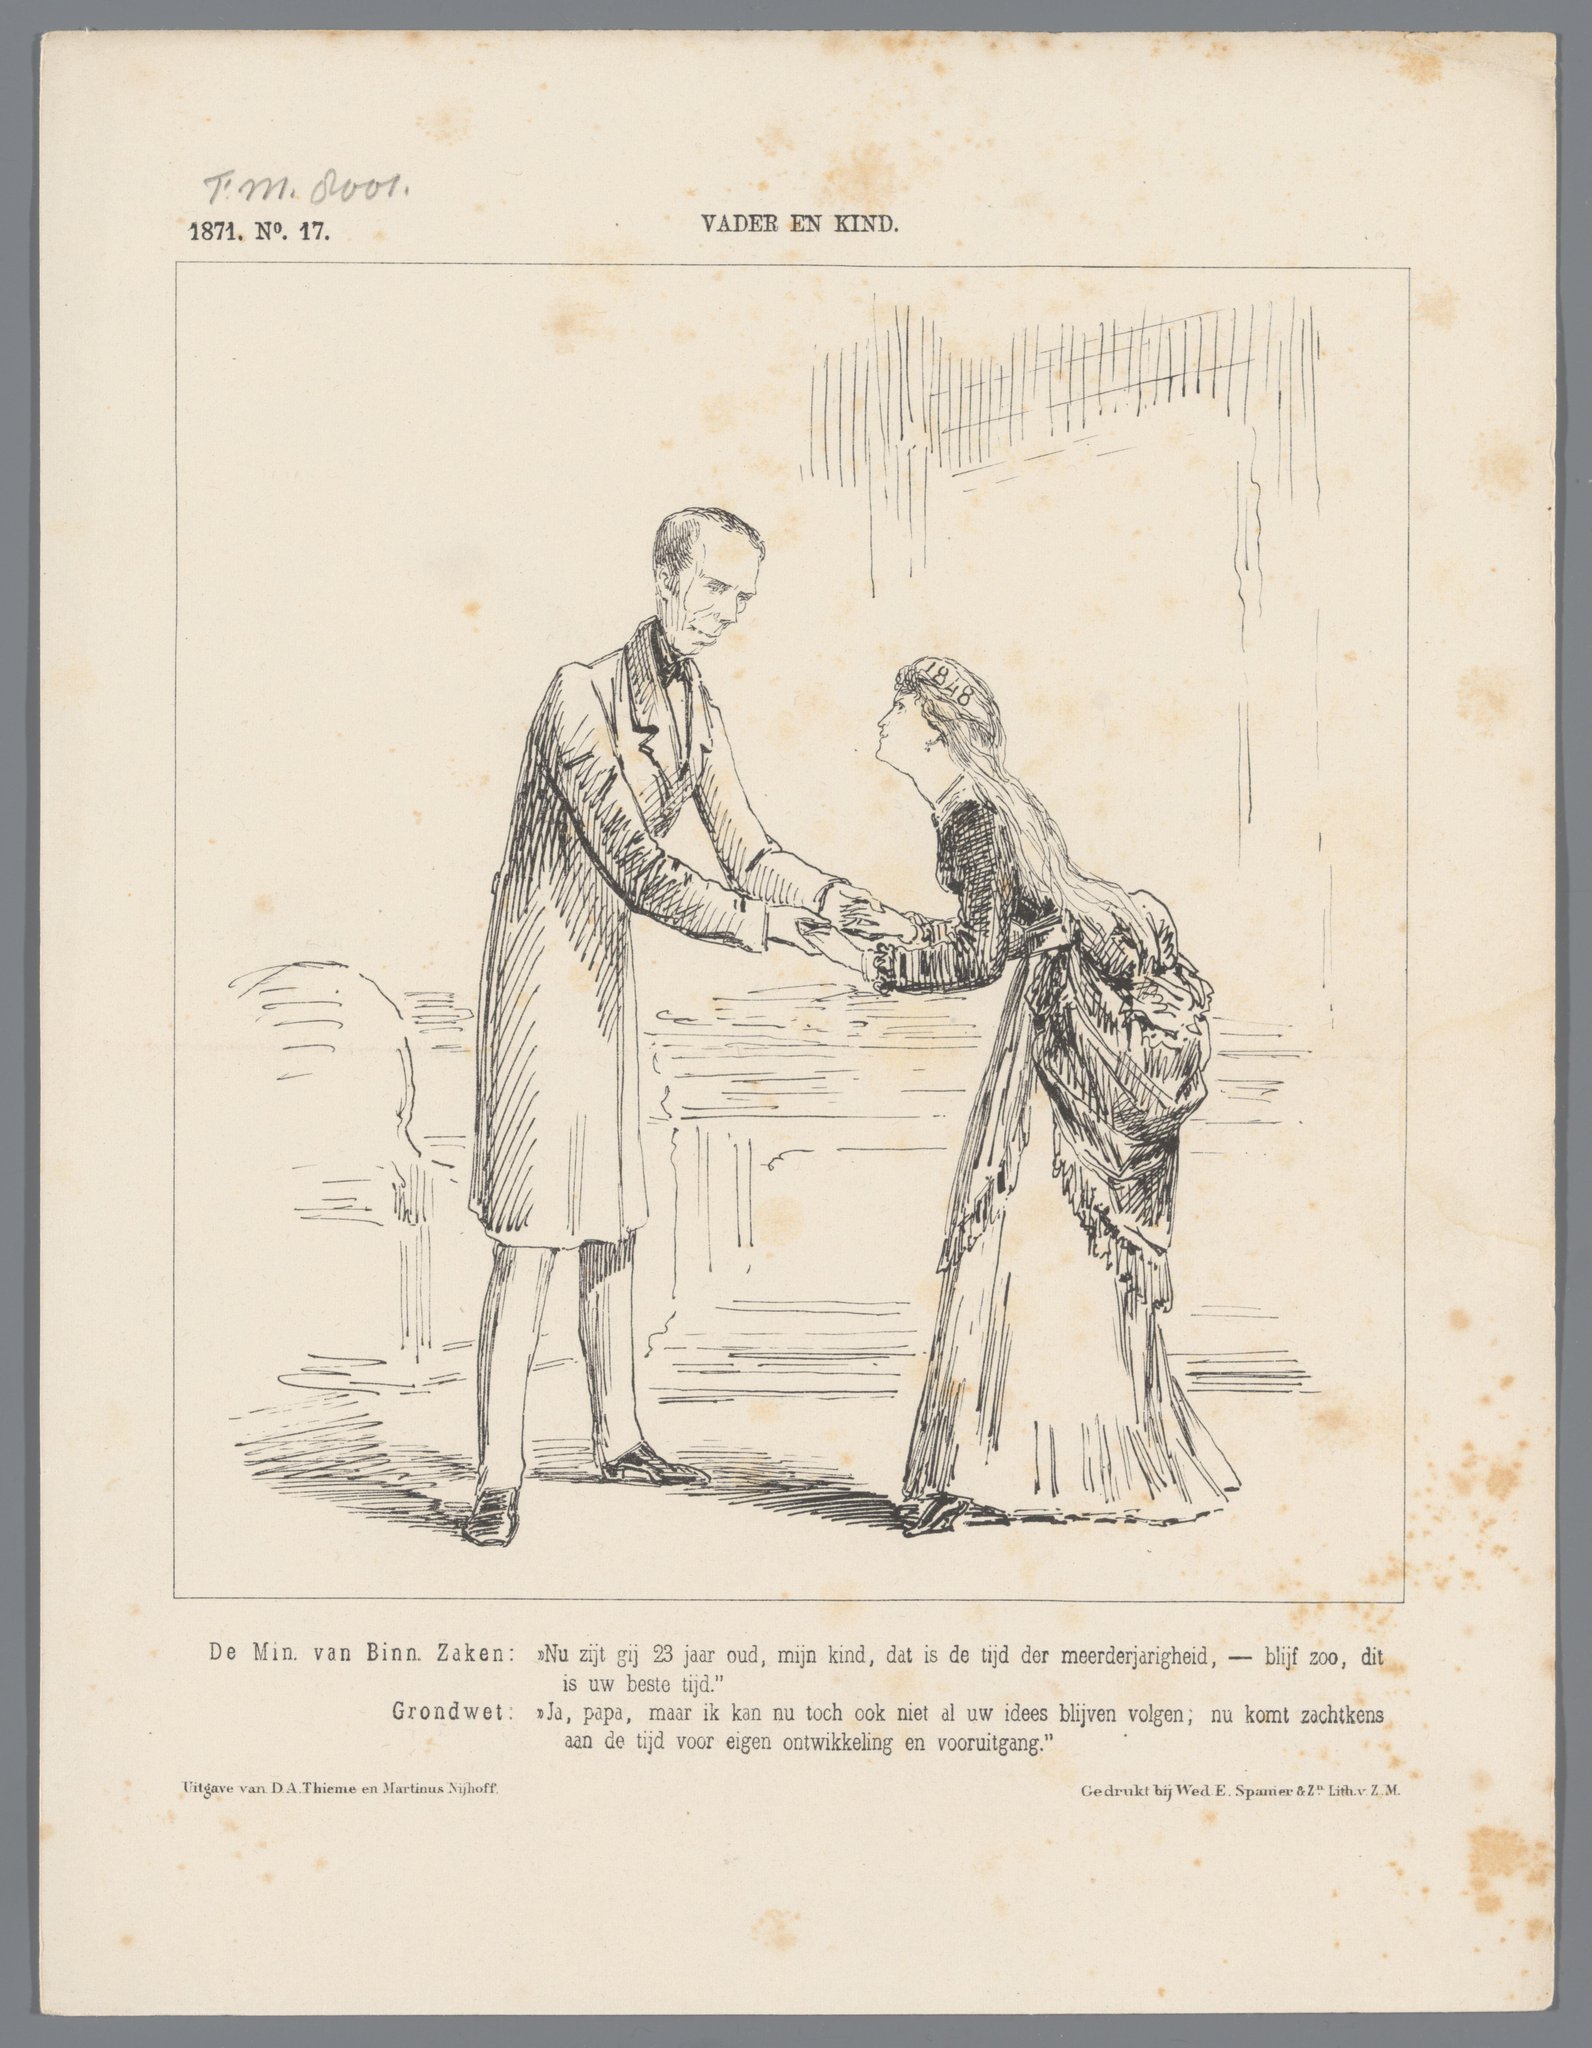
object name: cartoon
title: Vader en kind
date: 1871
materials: paper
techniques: lithograph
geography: the hague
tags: the hague, johan rudolf thorbecke, father with daughter(s) (father-love)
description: Spotprent op Thorbecke en de grondwet van 1848. Plaat verschenen bij het weekblad De Nederlandsche Spectator, nr. 17, 1871.